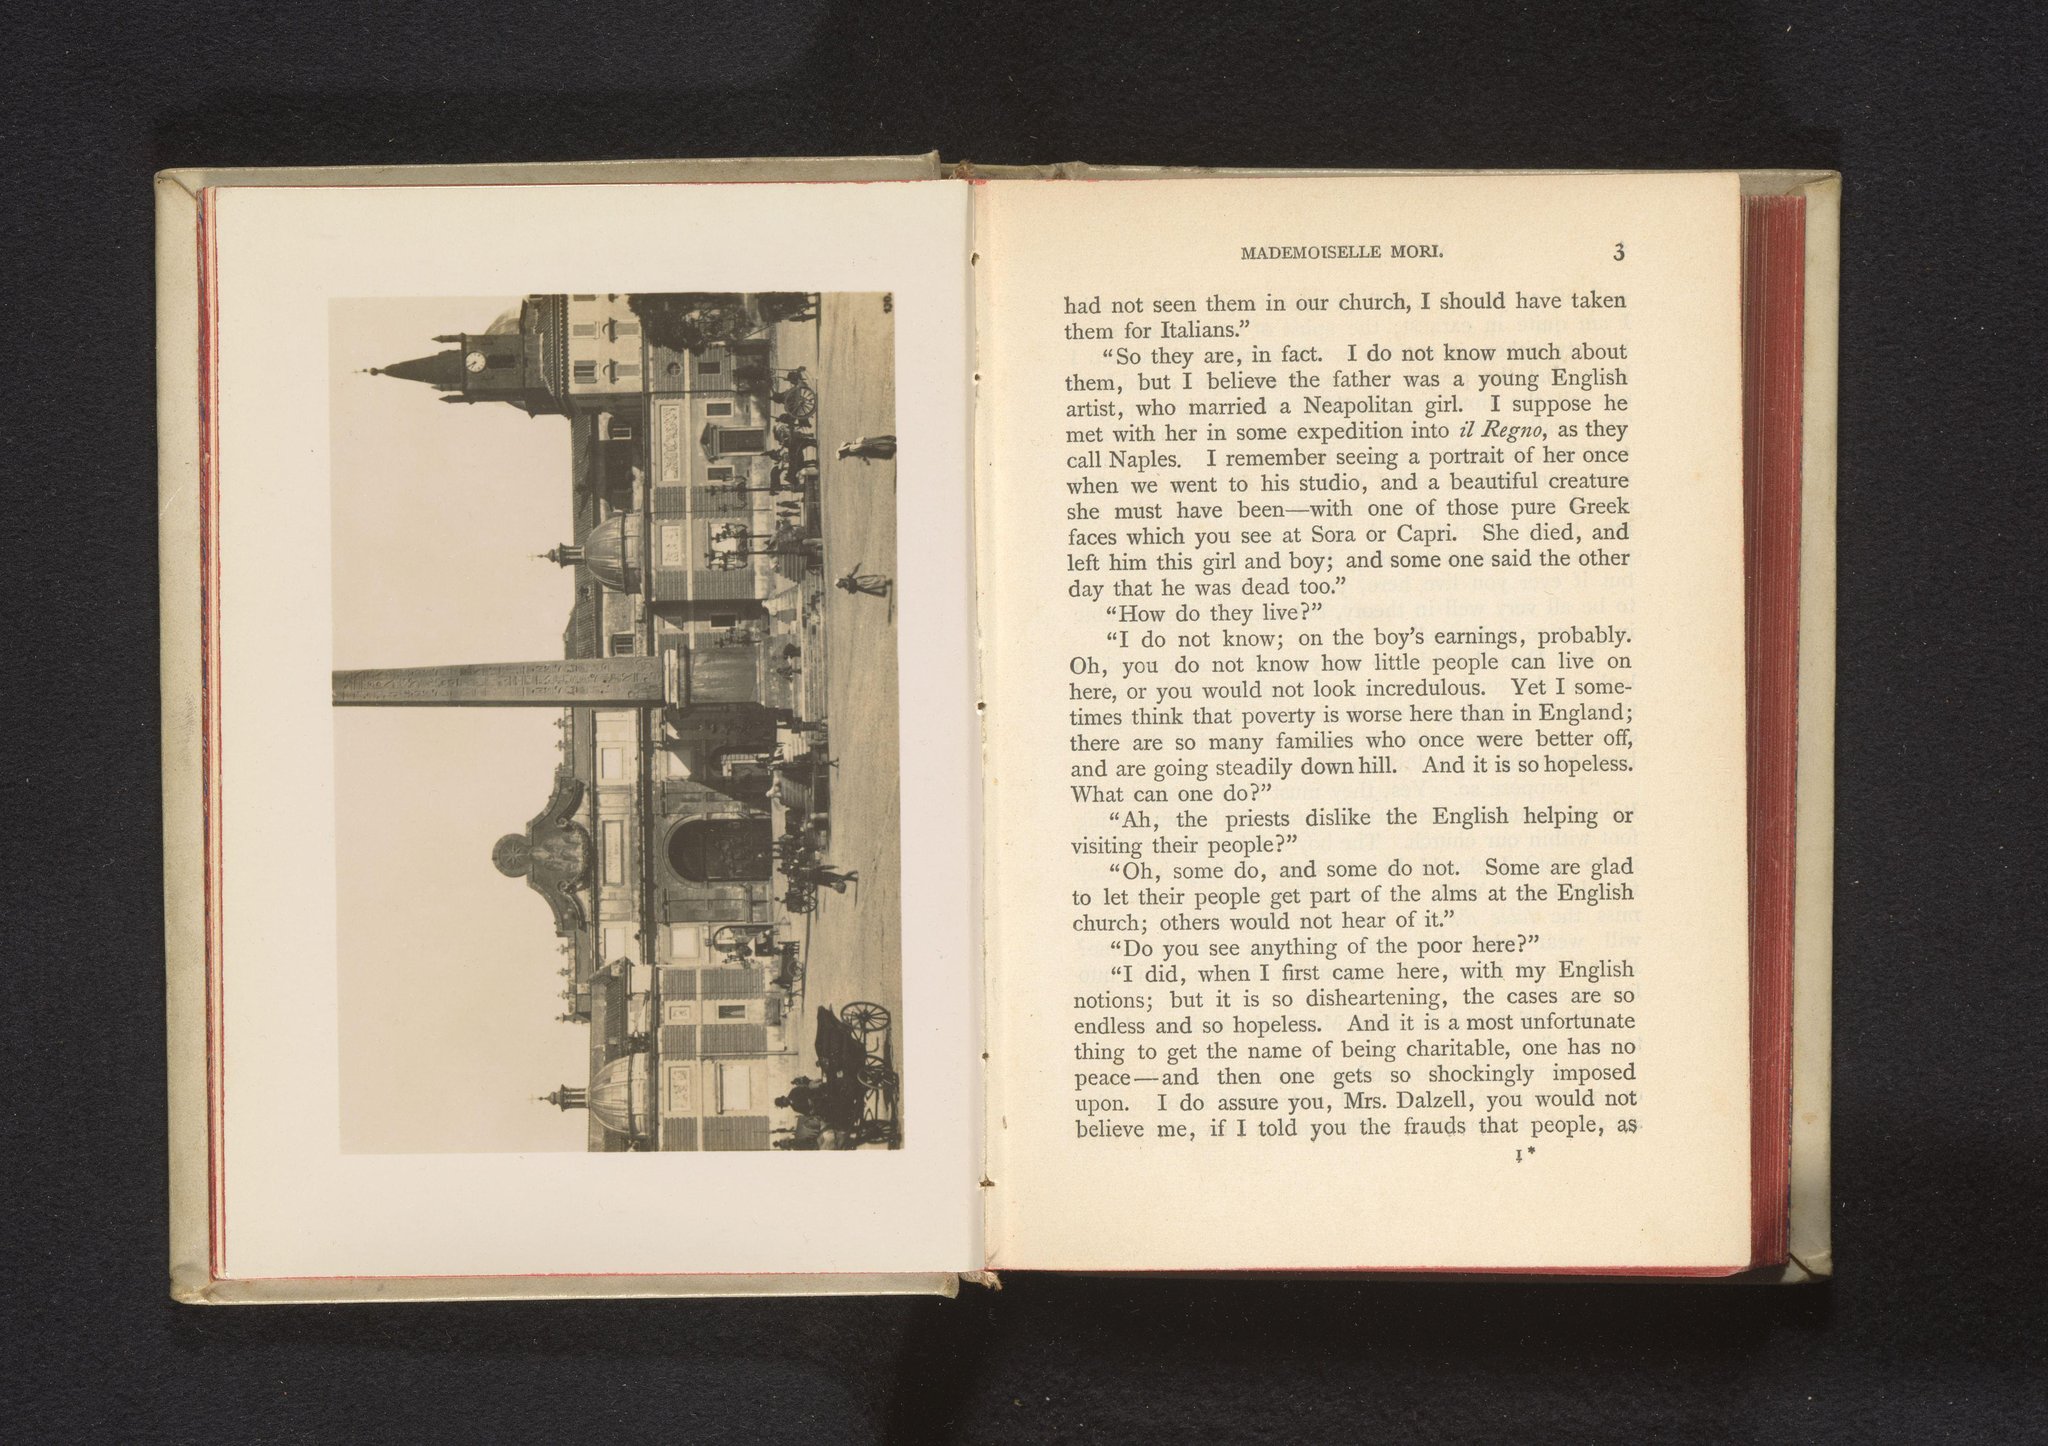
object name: page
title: Obelisk op het Piazza del Popolo te Rome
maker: Anonymous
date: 1852-1862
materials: photographic support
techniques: gelatin silver print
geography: piazza del popolo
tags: square, place, circus, etc., obelisk, needle